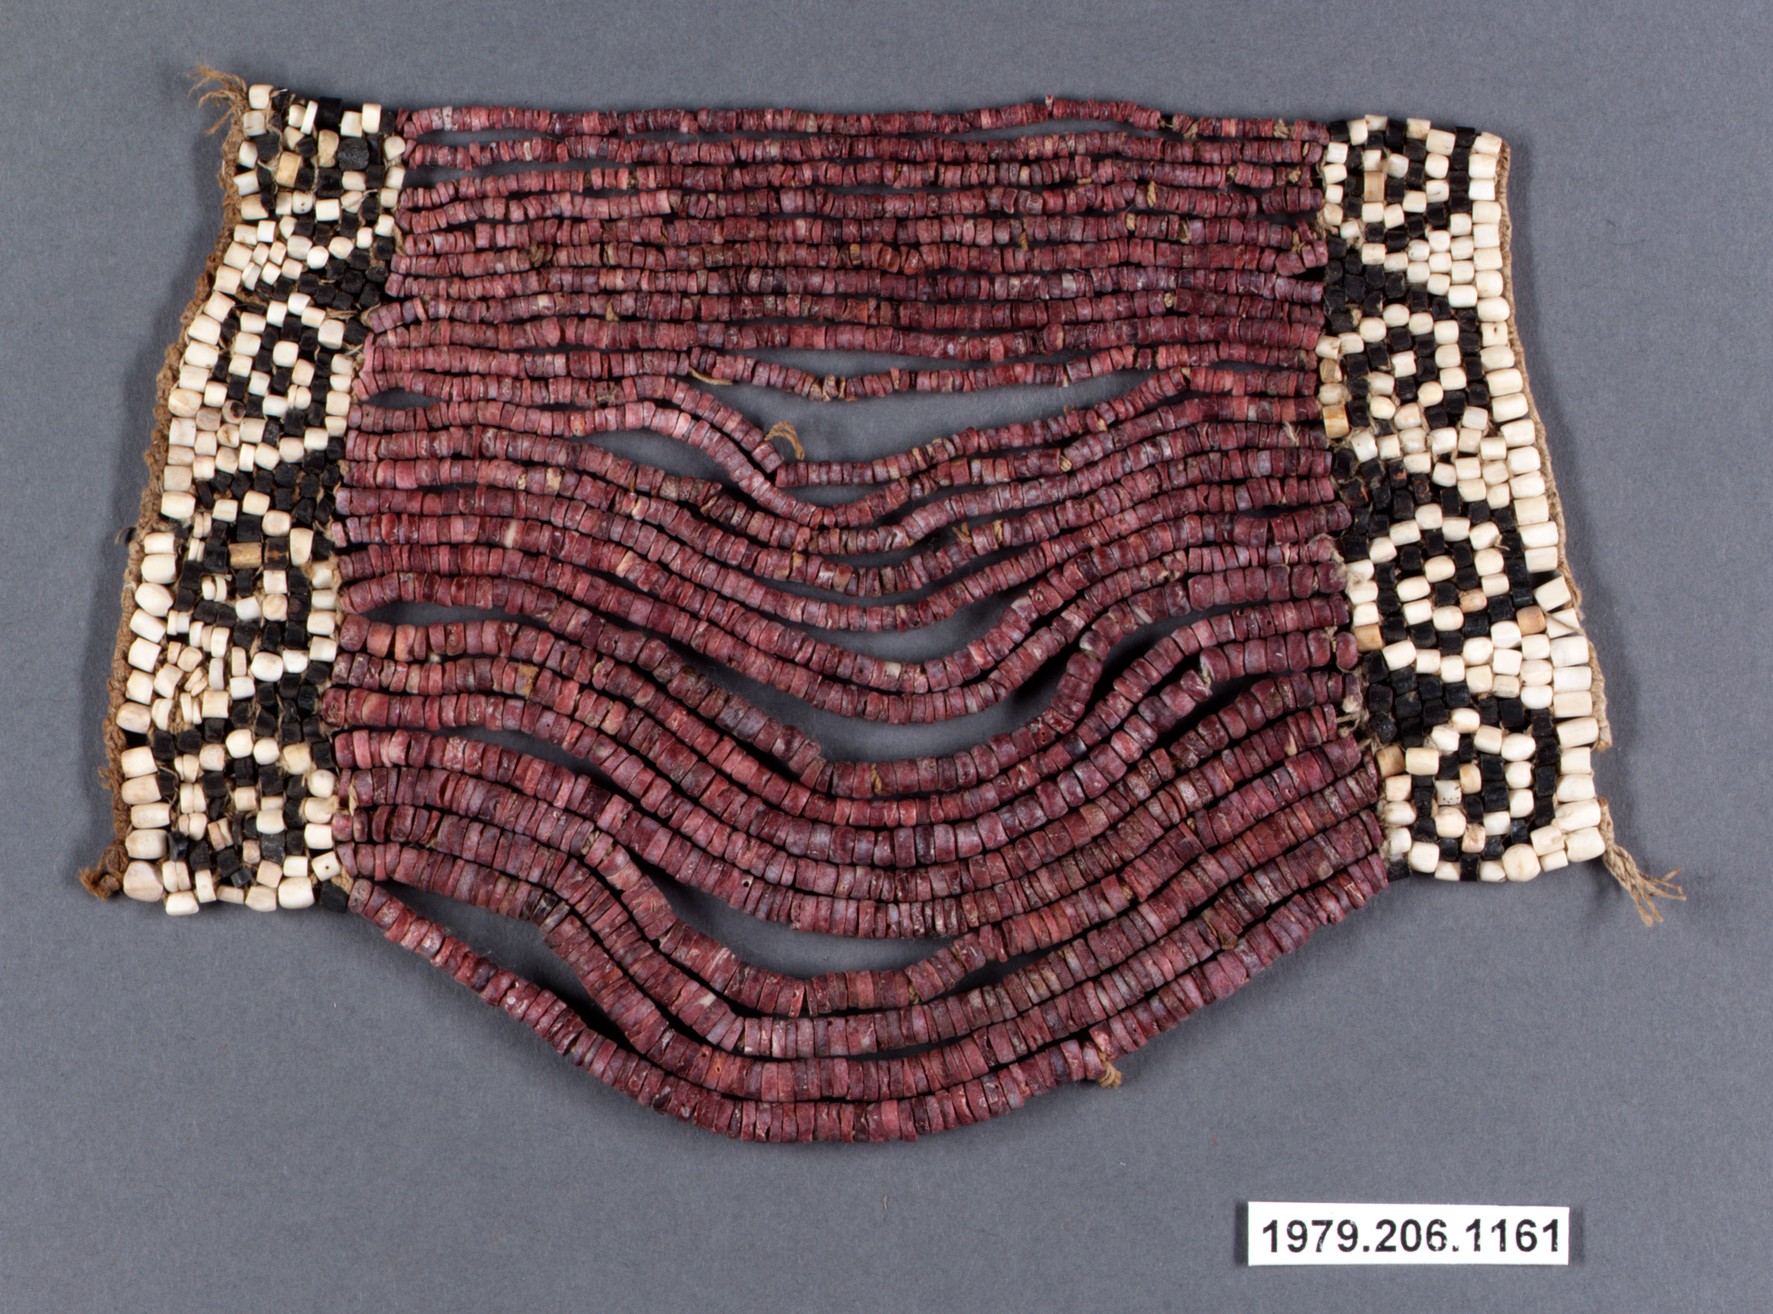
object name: bracelet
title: Beaded Wrist Ornament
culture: chancay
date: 1101-1400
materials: cord, shell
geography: peru